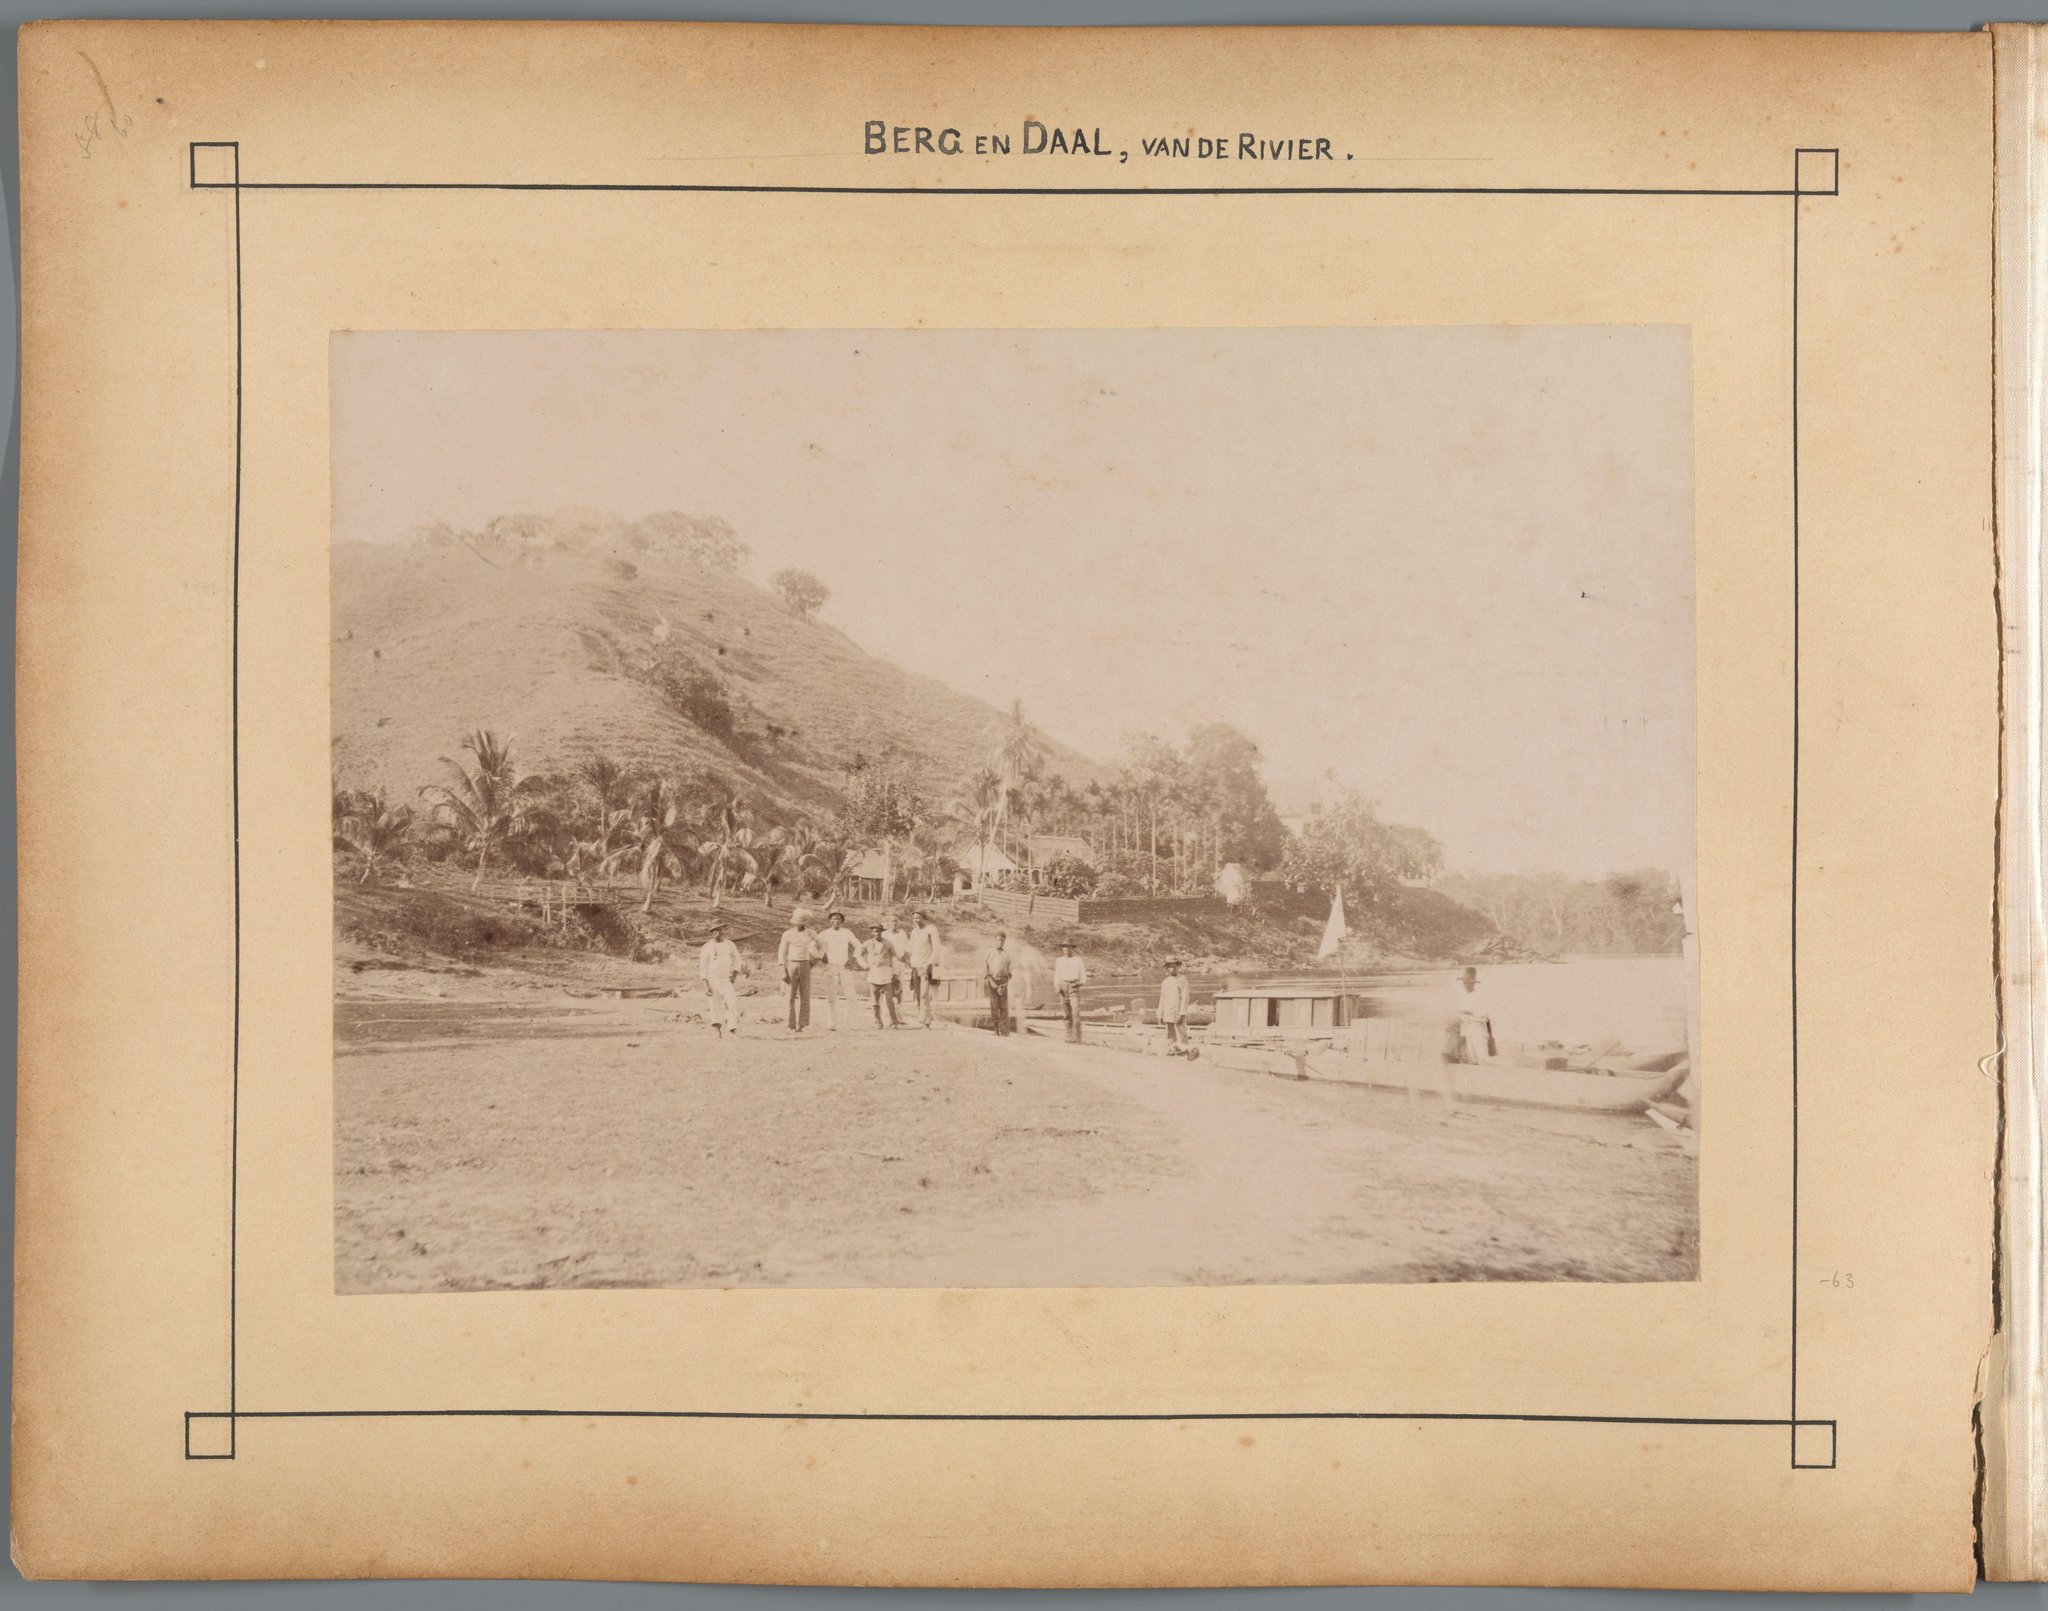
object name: photograph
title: Berg en Daal, van de rivier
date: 1898-1902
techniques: albumen print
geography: suriname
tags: plantation, suriname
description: Berg en Dal, een dorp en plantage in Suriname, gezien vanaf de rivier.